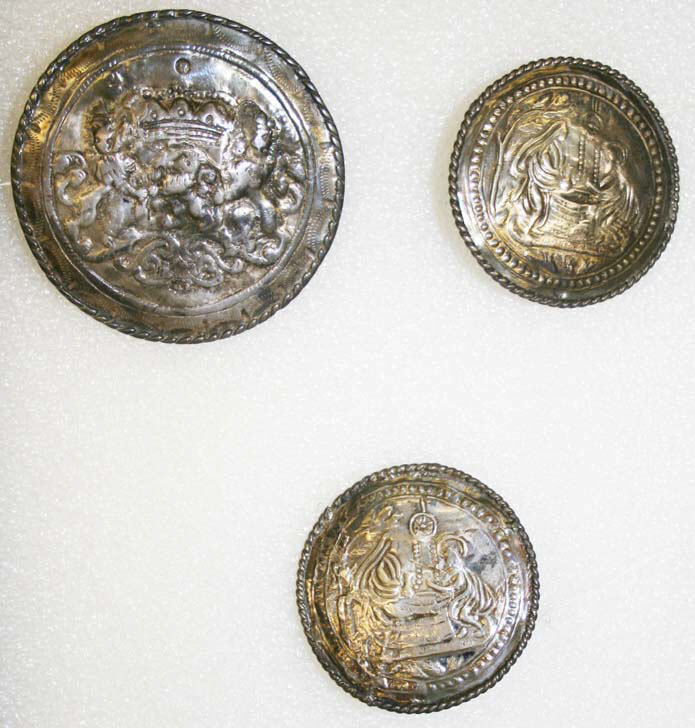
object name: button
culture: european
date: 1775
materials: silver